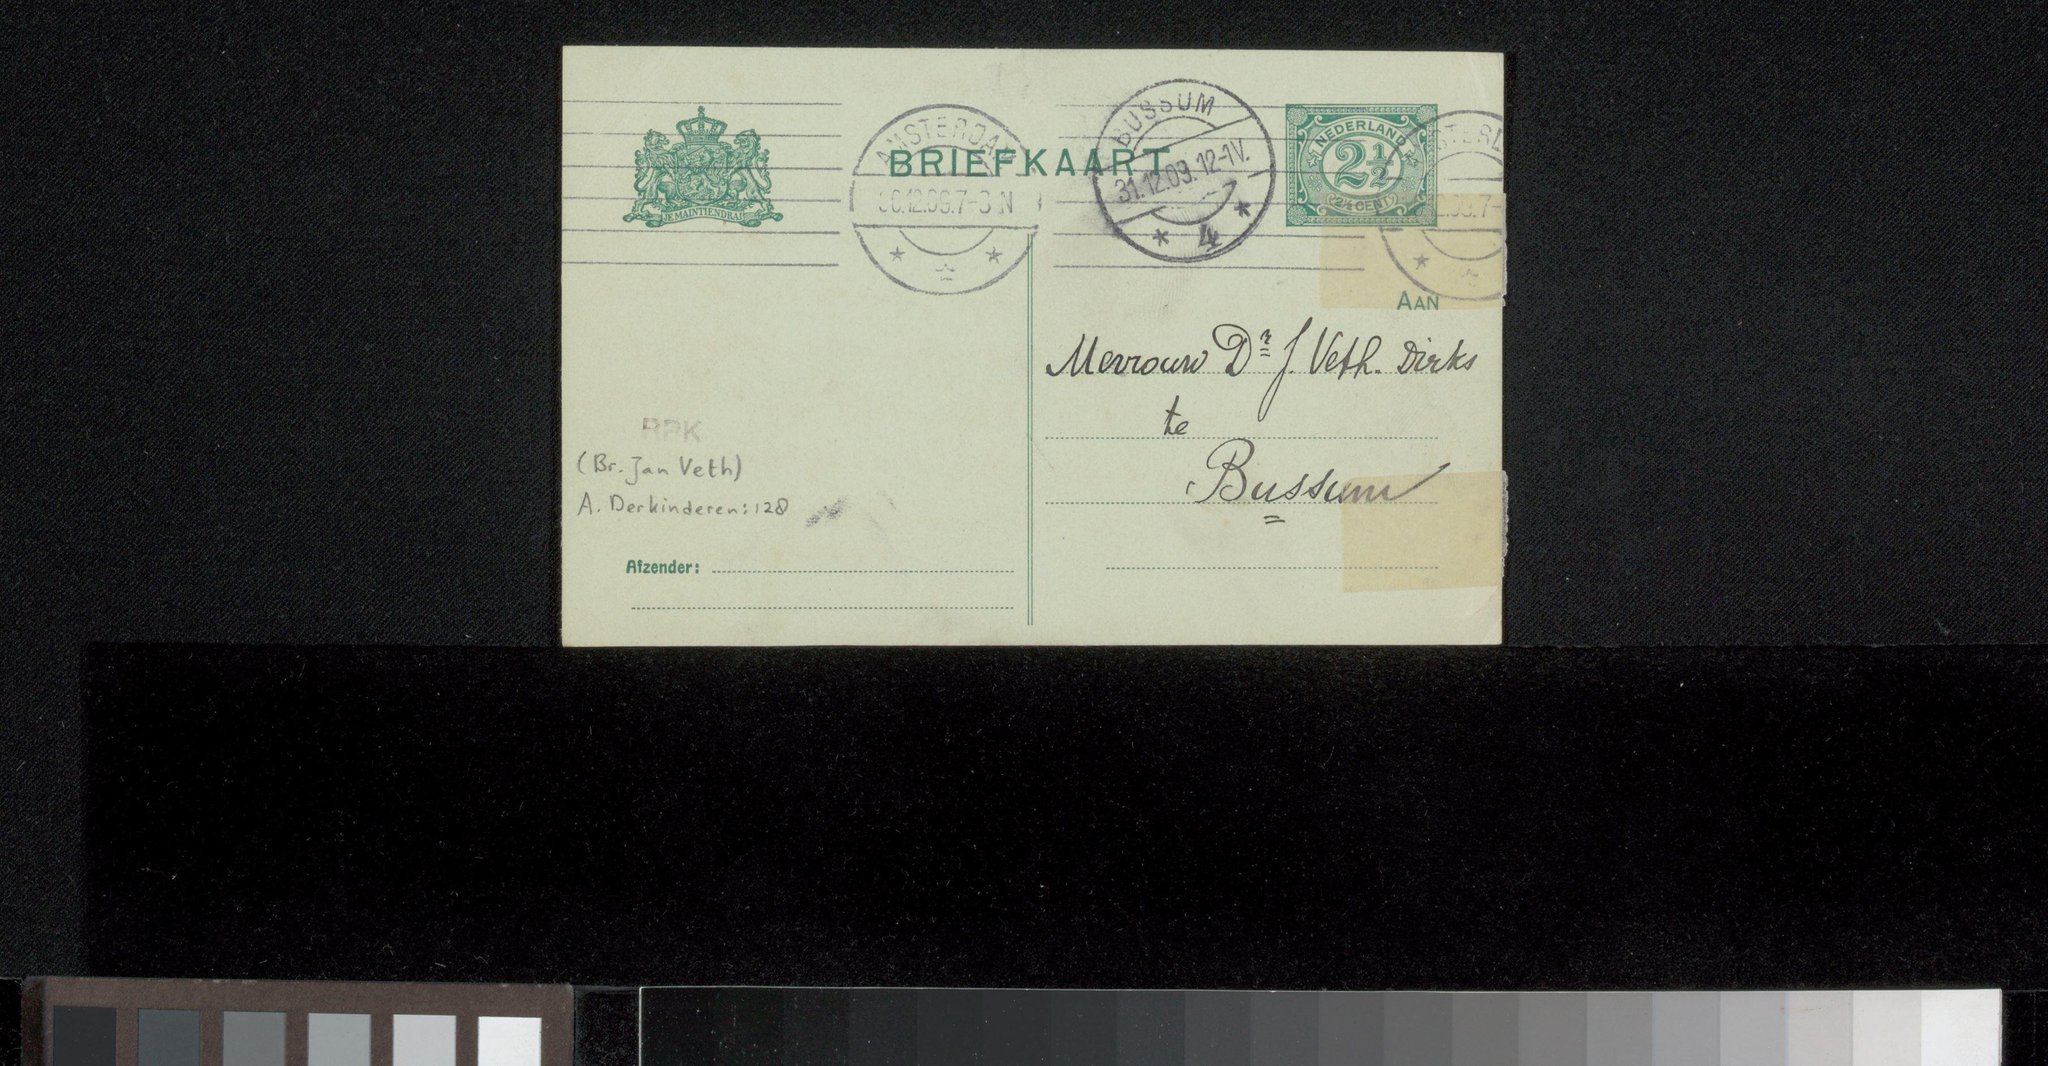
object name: postcard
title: Briefkaart aan Anna Dorothea Dirks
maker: antoon derkinderen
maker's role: draughtsman, painter, print maker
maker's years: 1859-1925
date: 1909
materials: cardboard, ink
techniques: pen, writing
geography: amsterdam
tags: artist, anna dorothea dirks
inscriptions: collector's mark: ‘RPK’